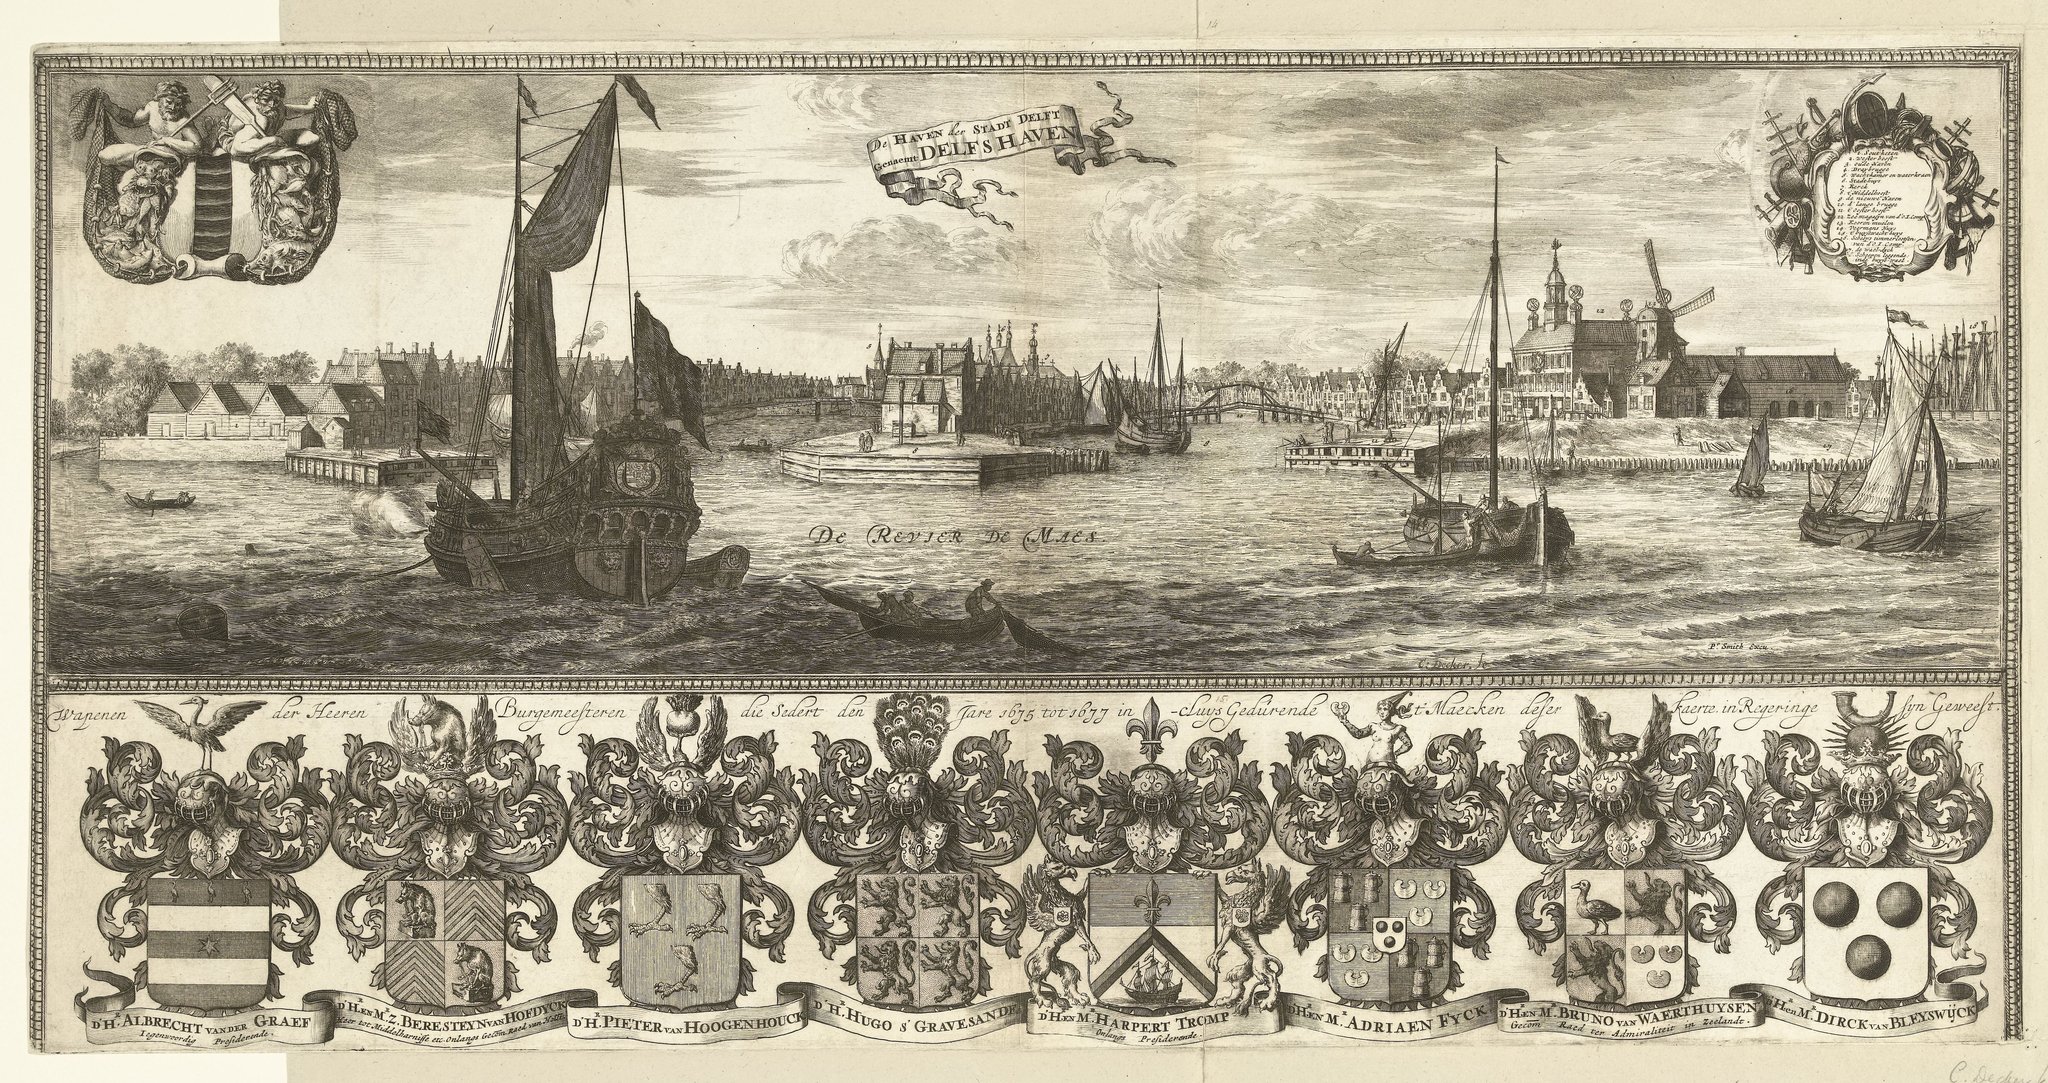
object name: print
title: Deel van de rand van de Kaart Figuratief van Delft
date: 1678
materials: paper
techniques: engraving, etching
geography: amsterdam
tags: harbour, coat of arms (as symbol of the state, etc.) (+ city; municipal), prospect of city, town panorama, silhouette of city, armorial bearing, heraldry, delfshaven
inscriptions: collector's mark: Lugt 2228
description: Voor tweede staat, zie RP-P-AO-13-51-2. Deze prent is onderdeel van de rand van de eerste uitgave van de zogenaamde Kaart Figuratief (Caerte figuratyff / Kaerte figuratyf) van Delft, een wandkaart van Delft. Deze kaart bestaat uit een plattegrond van Delft (RP-P-AO-11-8A) met daaromheen een rand. De rand bestaat uit een profiel van Delft (RP-P-AO-11-11), een profiel van Delfshaven met daaronder de wapenschilden van de burgemeesters van de stad (huidige prent en RP-P-AO-13-51-2), 24 kleinere prenten (kaarten, afbeeldingen van gebouwen en graven van bekende personen, o.a. RP-P-AO-11-15, RP-P-AO-11-16, RP-P-AO-11-17, RP-P-AO-11-18, RP-P-AO-11-19, RP-P-AO-11-20, RP-P-AO-11-21, RP-P-AO-11-23, RP-P-AO-11-24, RP-P-AO-11-27, RP-P-AO-11-28, RP-P-AO-11-29, RP-P-AO-11-30, RP-P-AO-11-31, RP-P-AO-11-33C, RP-P-AO-11-34, RP-P-AO-11-35, RP-P-AO-11-35-2, RP-P-AO-13-49, RP-P-AO-13-52, RP-P-AO-13-53, RP-P-AO-13-54-1 en RP-P-1909-6463) en een beschrijving van de stad (RP-P-AO-11-8E). De eerste druk van deze Kaart Figuratief (1678) werd, in opdracht van het Delftse stadsbestuur, verzorgd door Pieter Smith. Pieter Mortier (I) verzorgde in 1703, tevens in opdracht van het stadsbestuur, een tweede uitgave van de Kaart Figuratief. Voor deze druk bracht graveur Thomas van der Wilt enkele aanpassingen aan op de platen van de plattegrond. De randplaten lijken, op de plaat van de huidige prent na, ongewijzigd te zijn gebleven. De plattegrond is in 1752, waarschijnlijk zonder de randprenten, opnieuw uitgegeven.